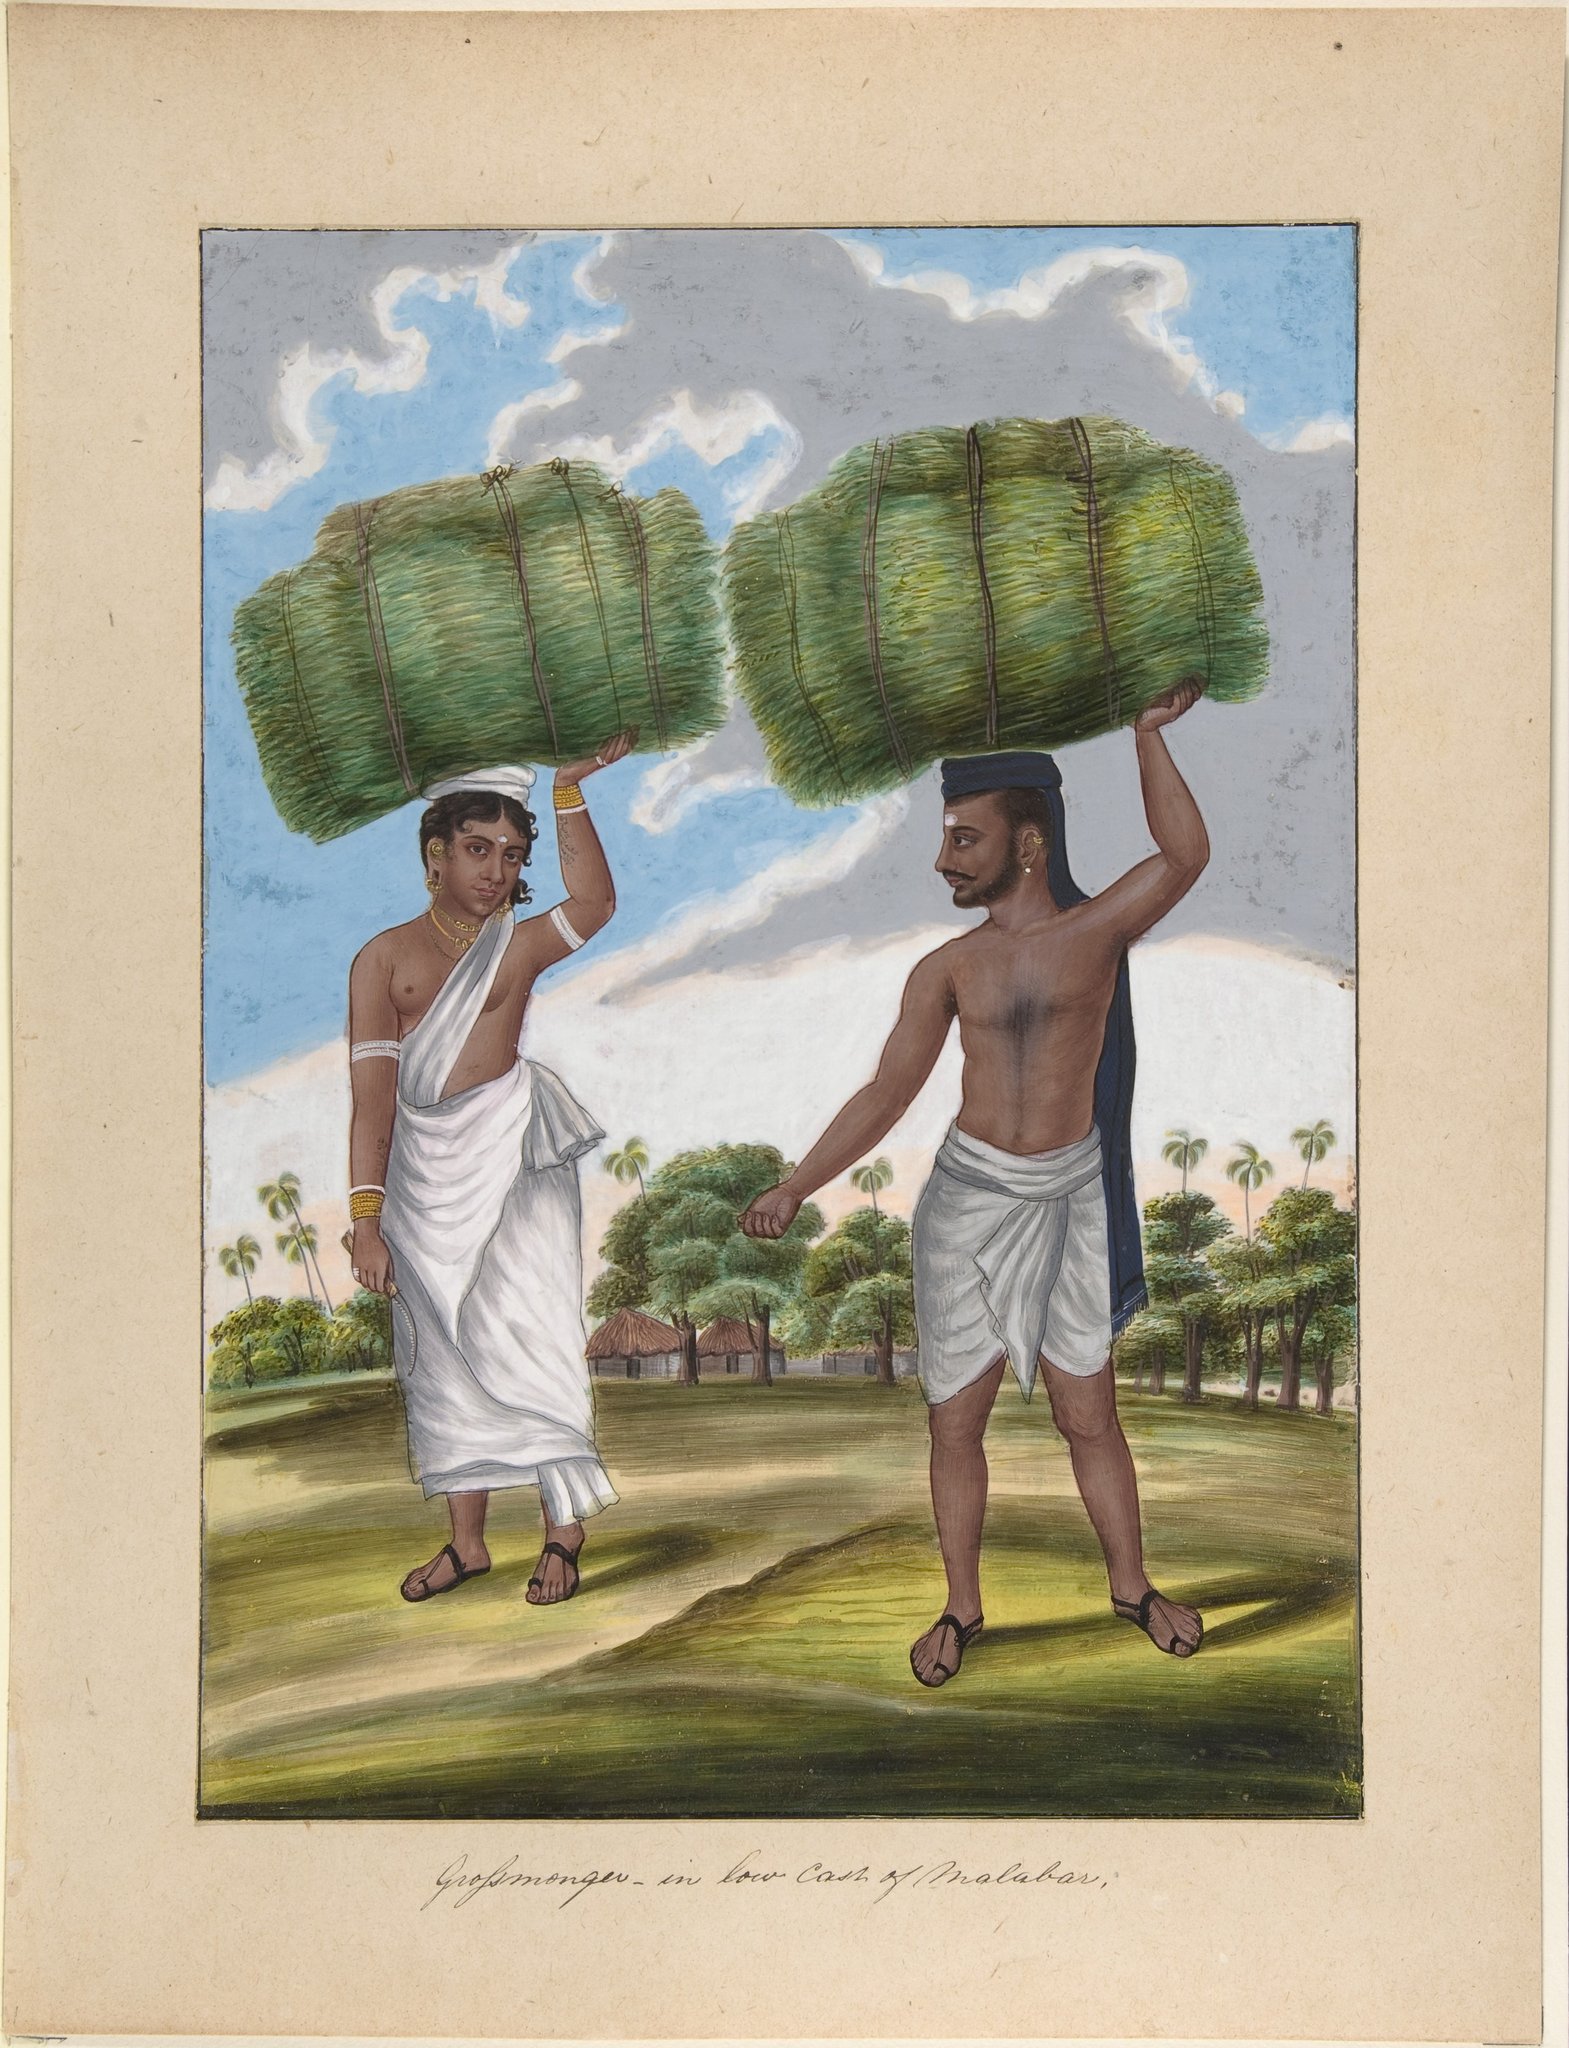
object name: drawing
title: Grossmonger, in Low Cast of Malabar, from Indian Trades and Castes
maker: anonymous, indian, 19th century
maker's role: artist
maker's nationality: indian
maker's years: 1800-1900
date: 1840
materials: gouache, watercolor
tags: men,women,working